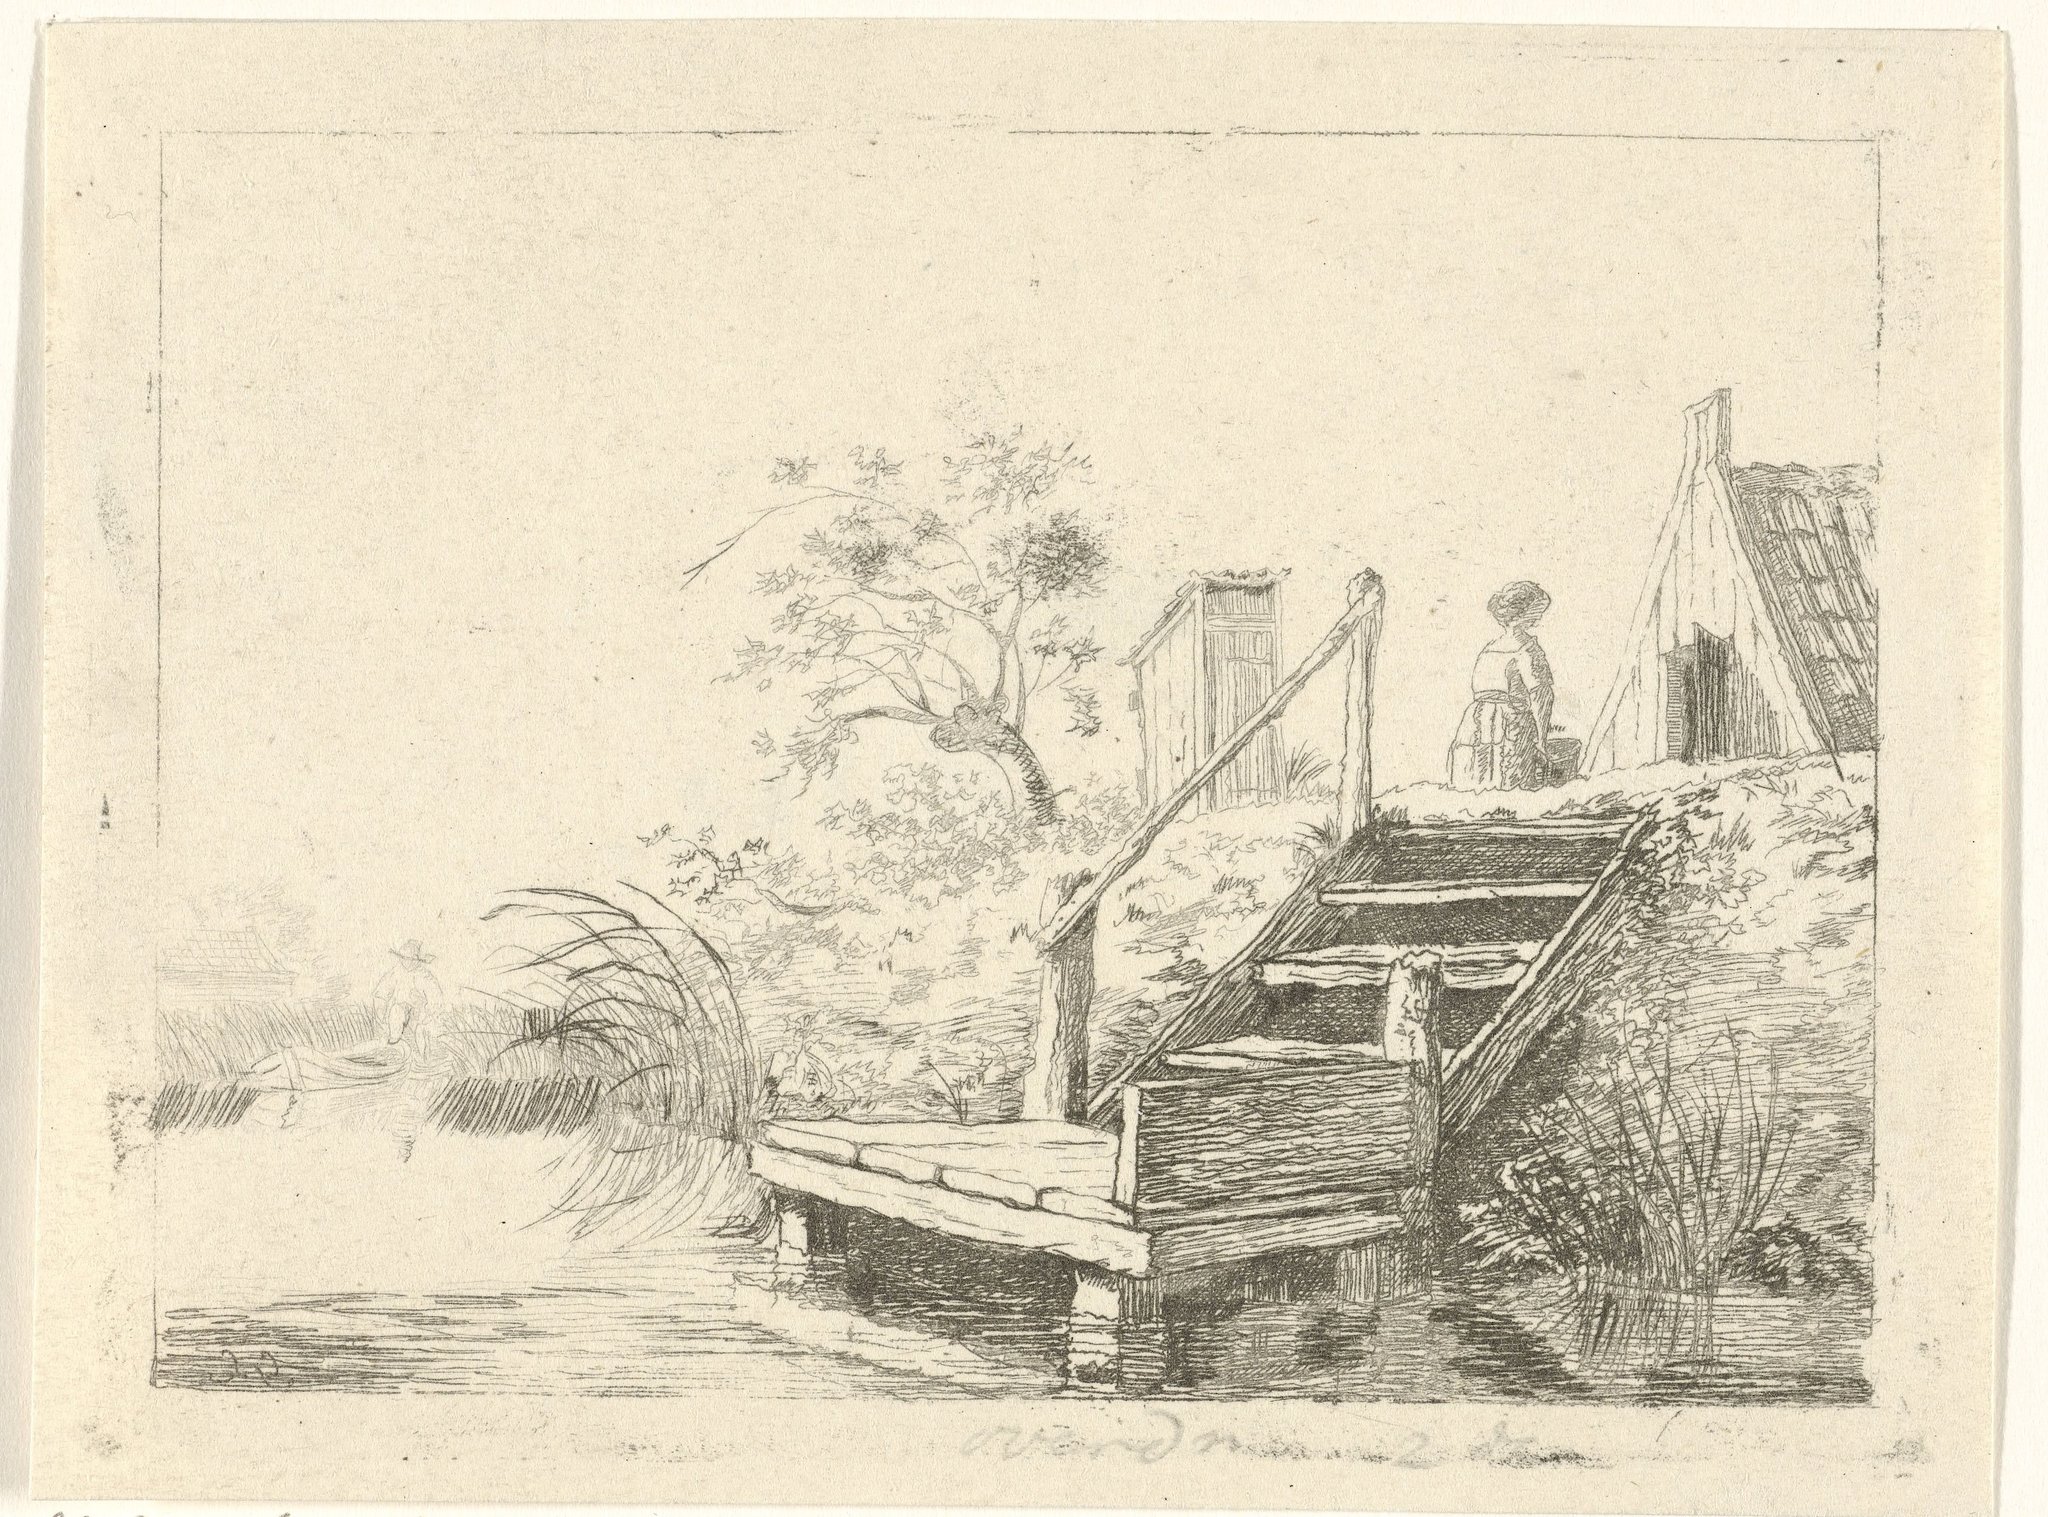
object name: print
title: Trap aan het water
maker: gerrit lamberts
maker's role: bookseller, draughtsman, print maker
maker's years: 1776-1850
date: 1810-1850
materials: paper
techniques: printmaking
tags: dikes, levee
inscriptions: collector's mark: Lugt 2228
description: Trap met vlonder aan het water. Op de dijk loopt een vrouw richting huis. Tegenafdruk van gelijknamige prent.